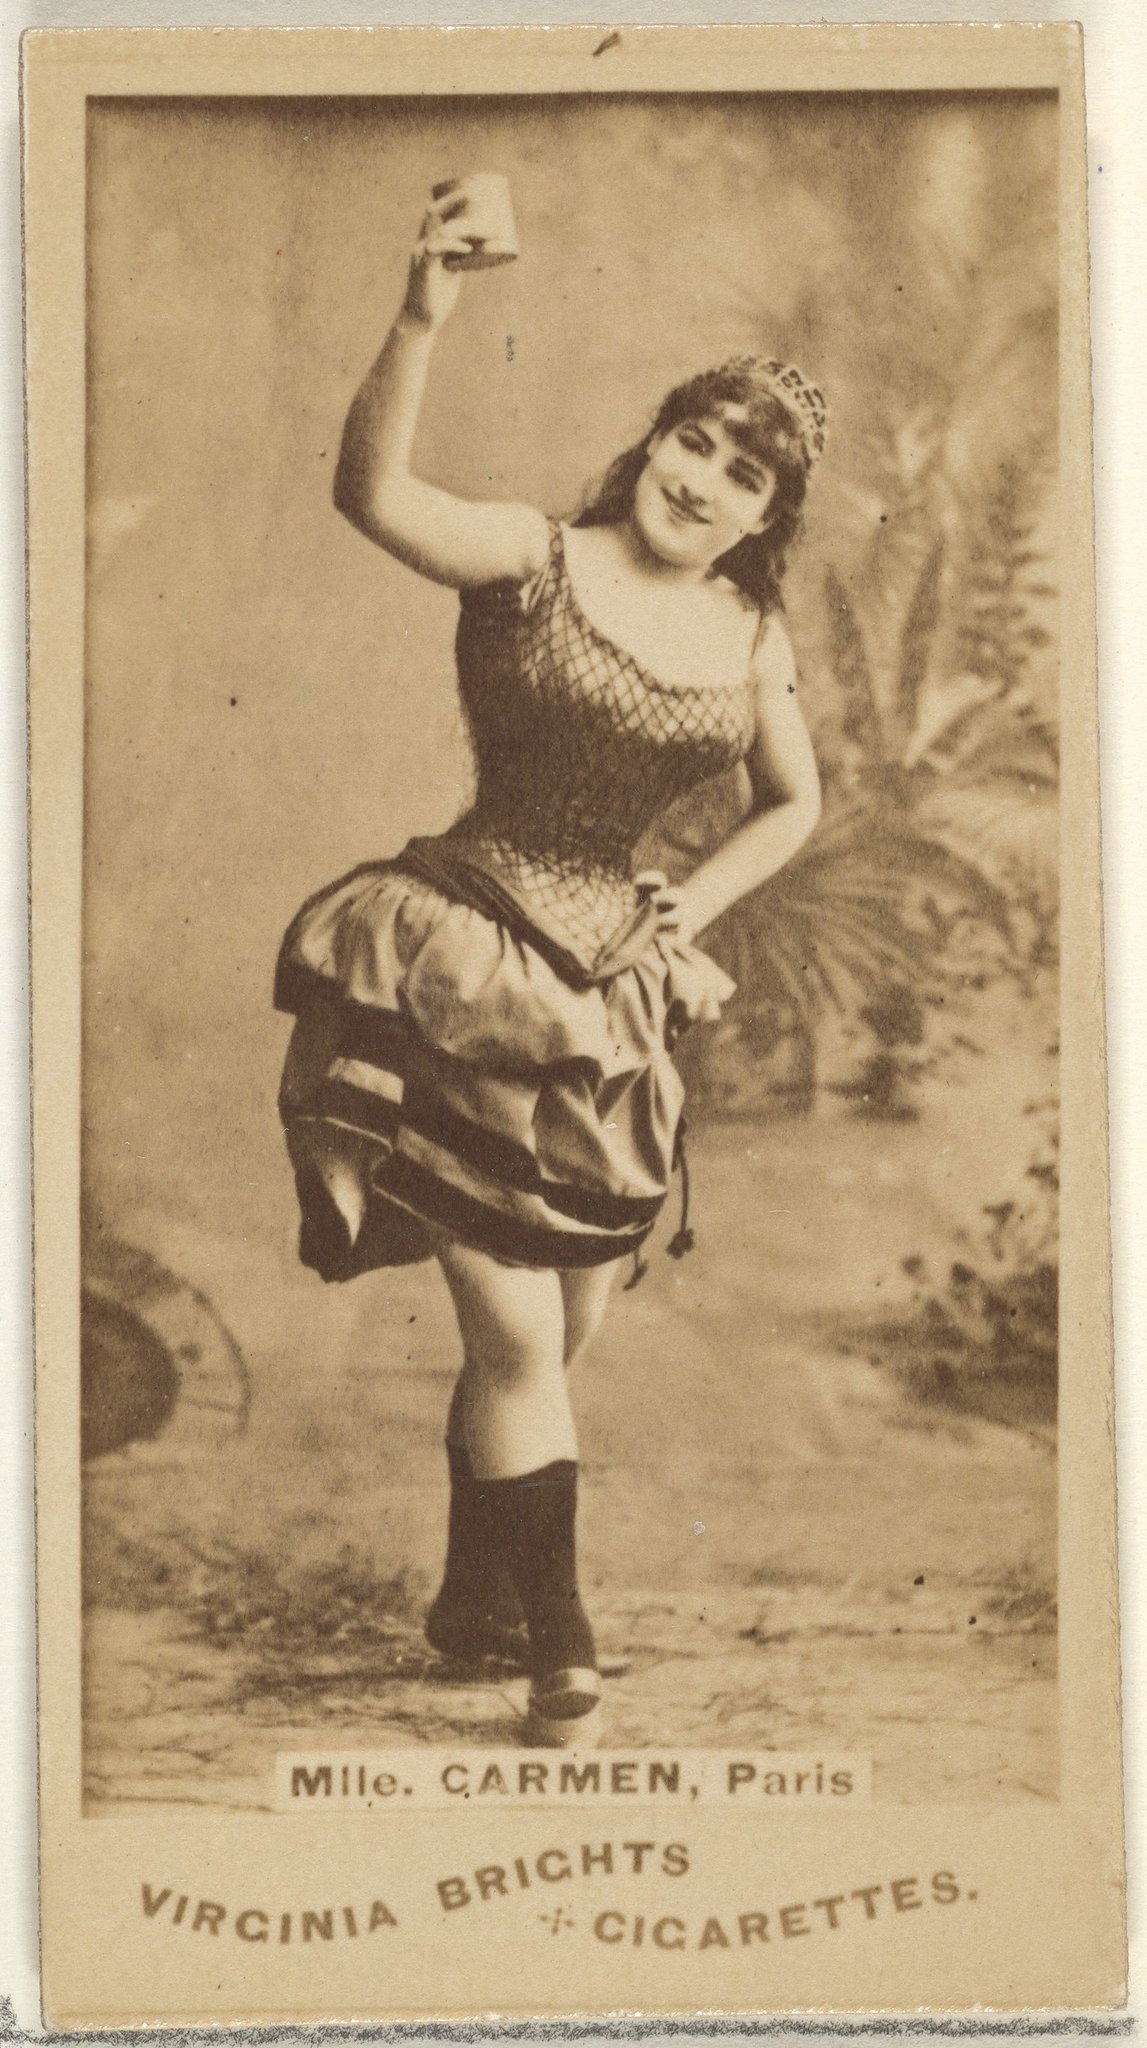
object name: photograph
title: Mlle. Carmen, Paris, from the Actors and Actresses series (N45, Type 1) for Virginia Brights Cigarettes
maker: allen & ginter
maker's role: publisher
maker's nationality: american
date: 1888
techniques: albumen silver print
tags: portraits,women,actresses